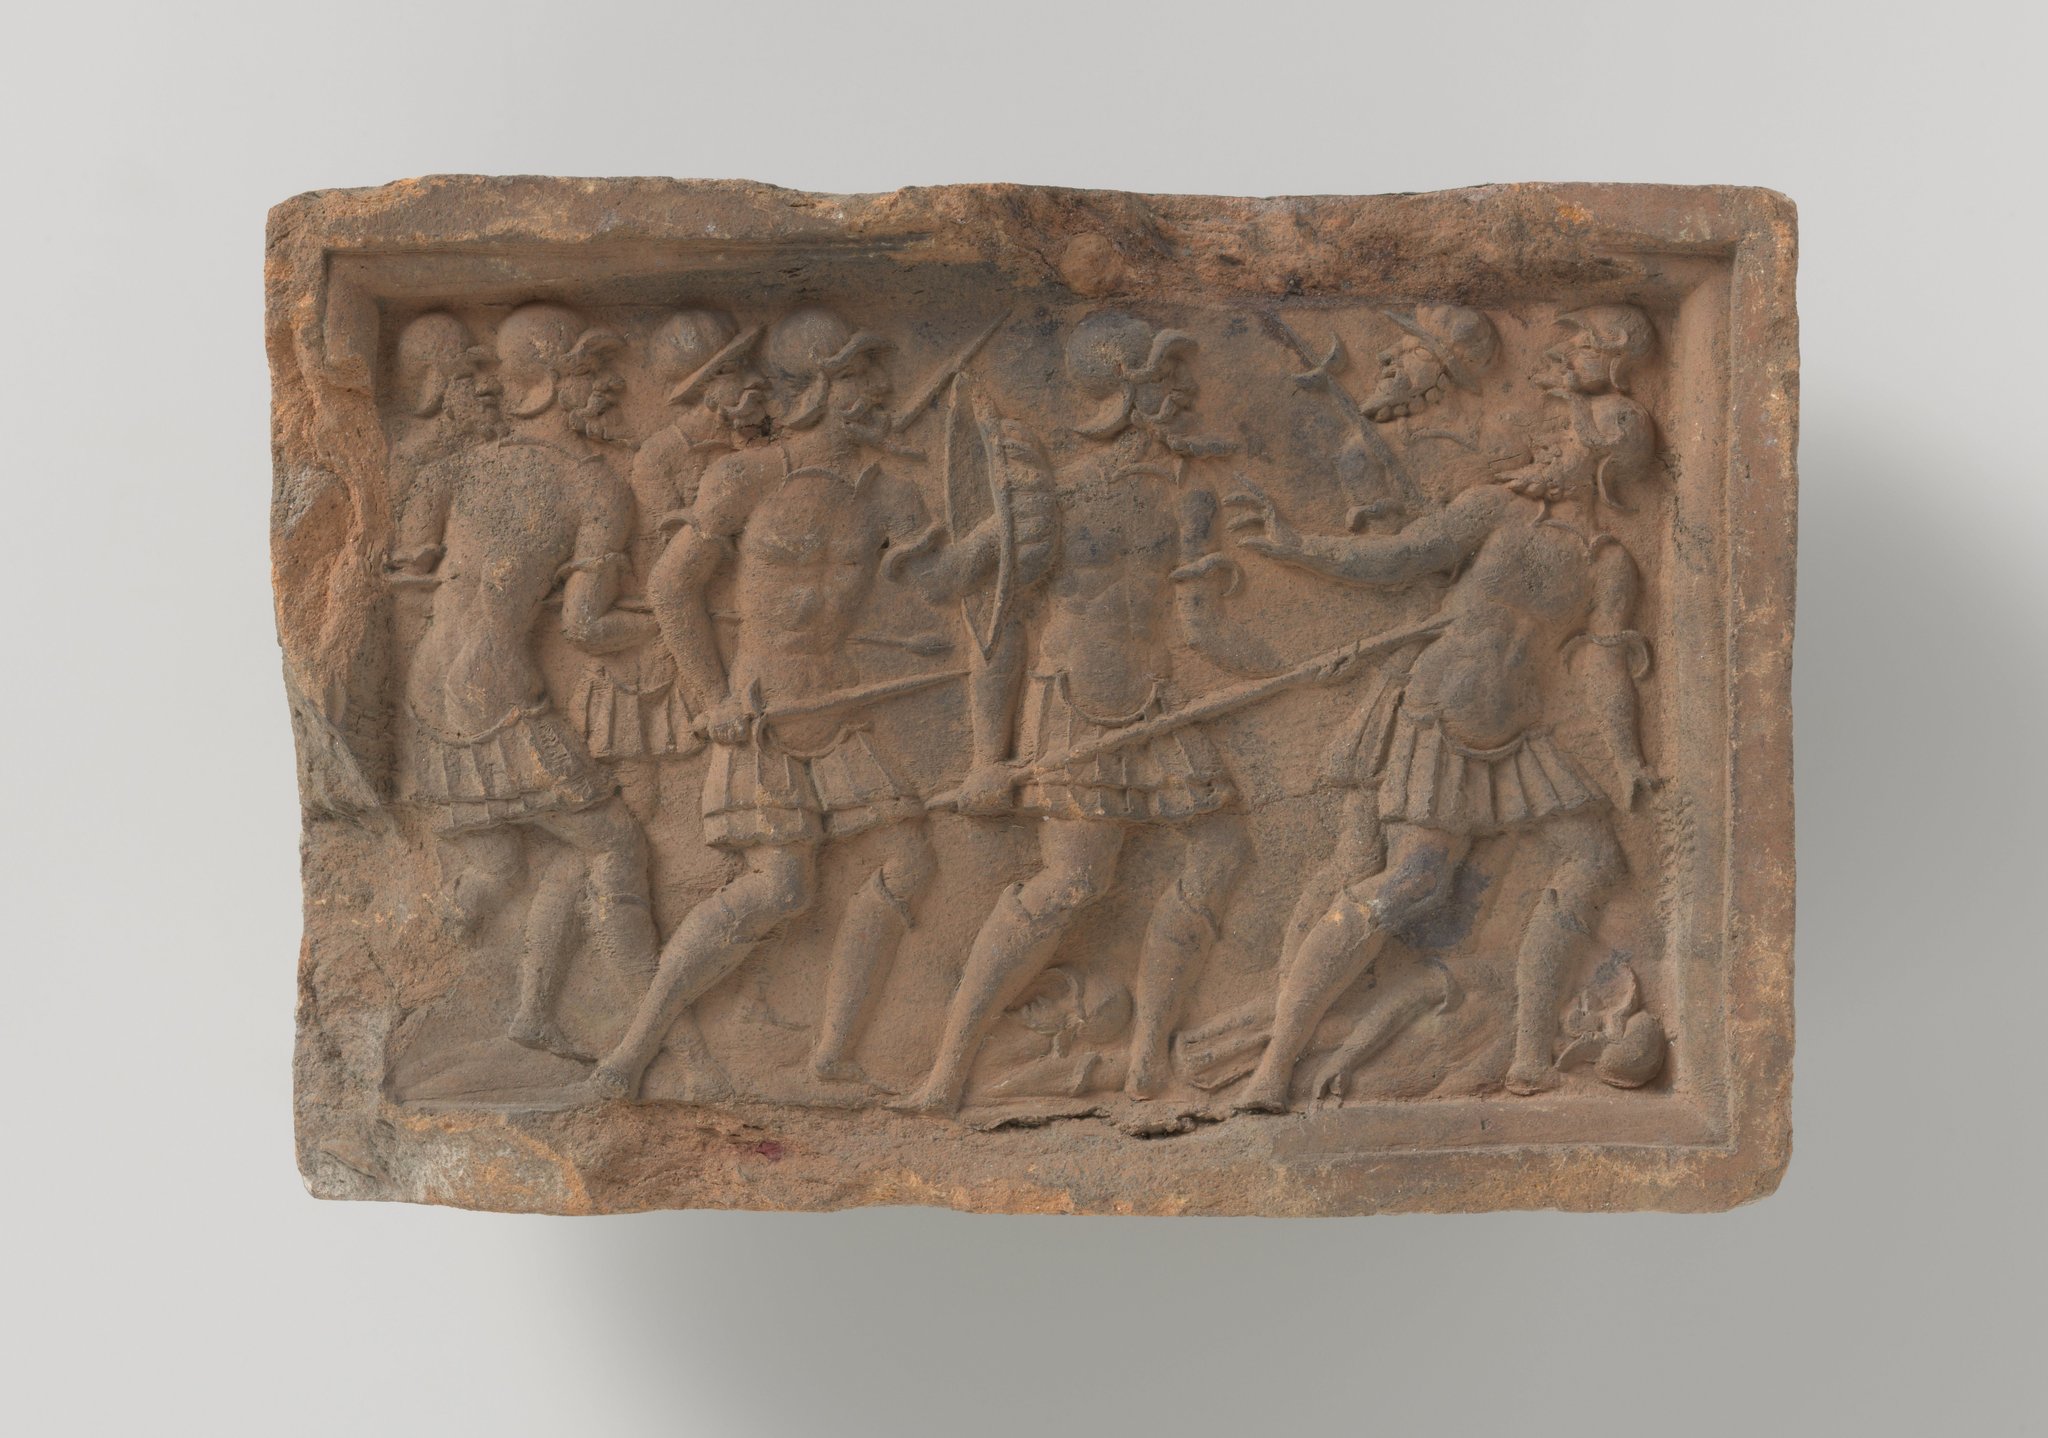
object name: hearthstone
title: Haardsteen met voorstelling van aanvallende krijgslieden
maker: Anonymous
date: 1400-1950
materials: earthenware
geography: southern netherlands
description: Haardsteen met voorstelling van aanvallende krijgslieden.